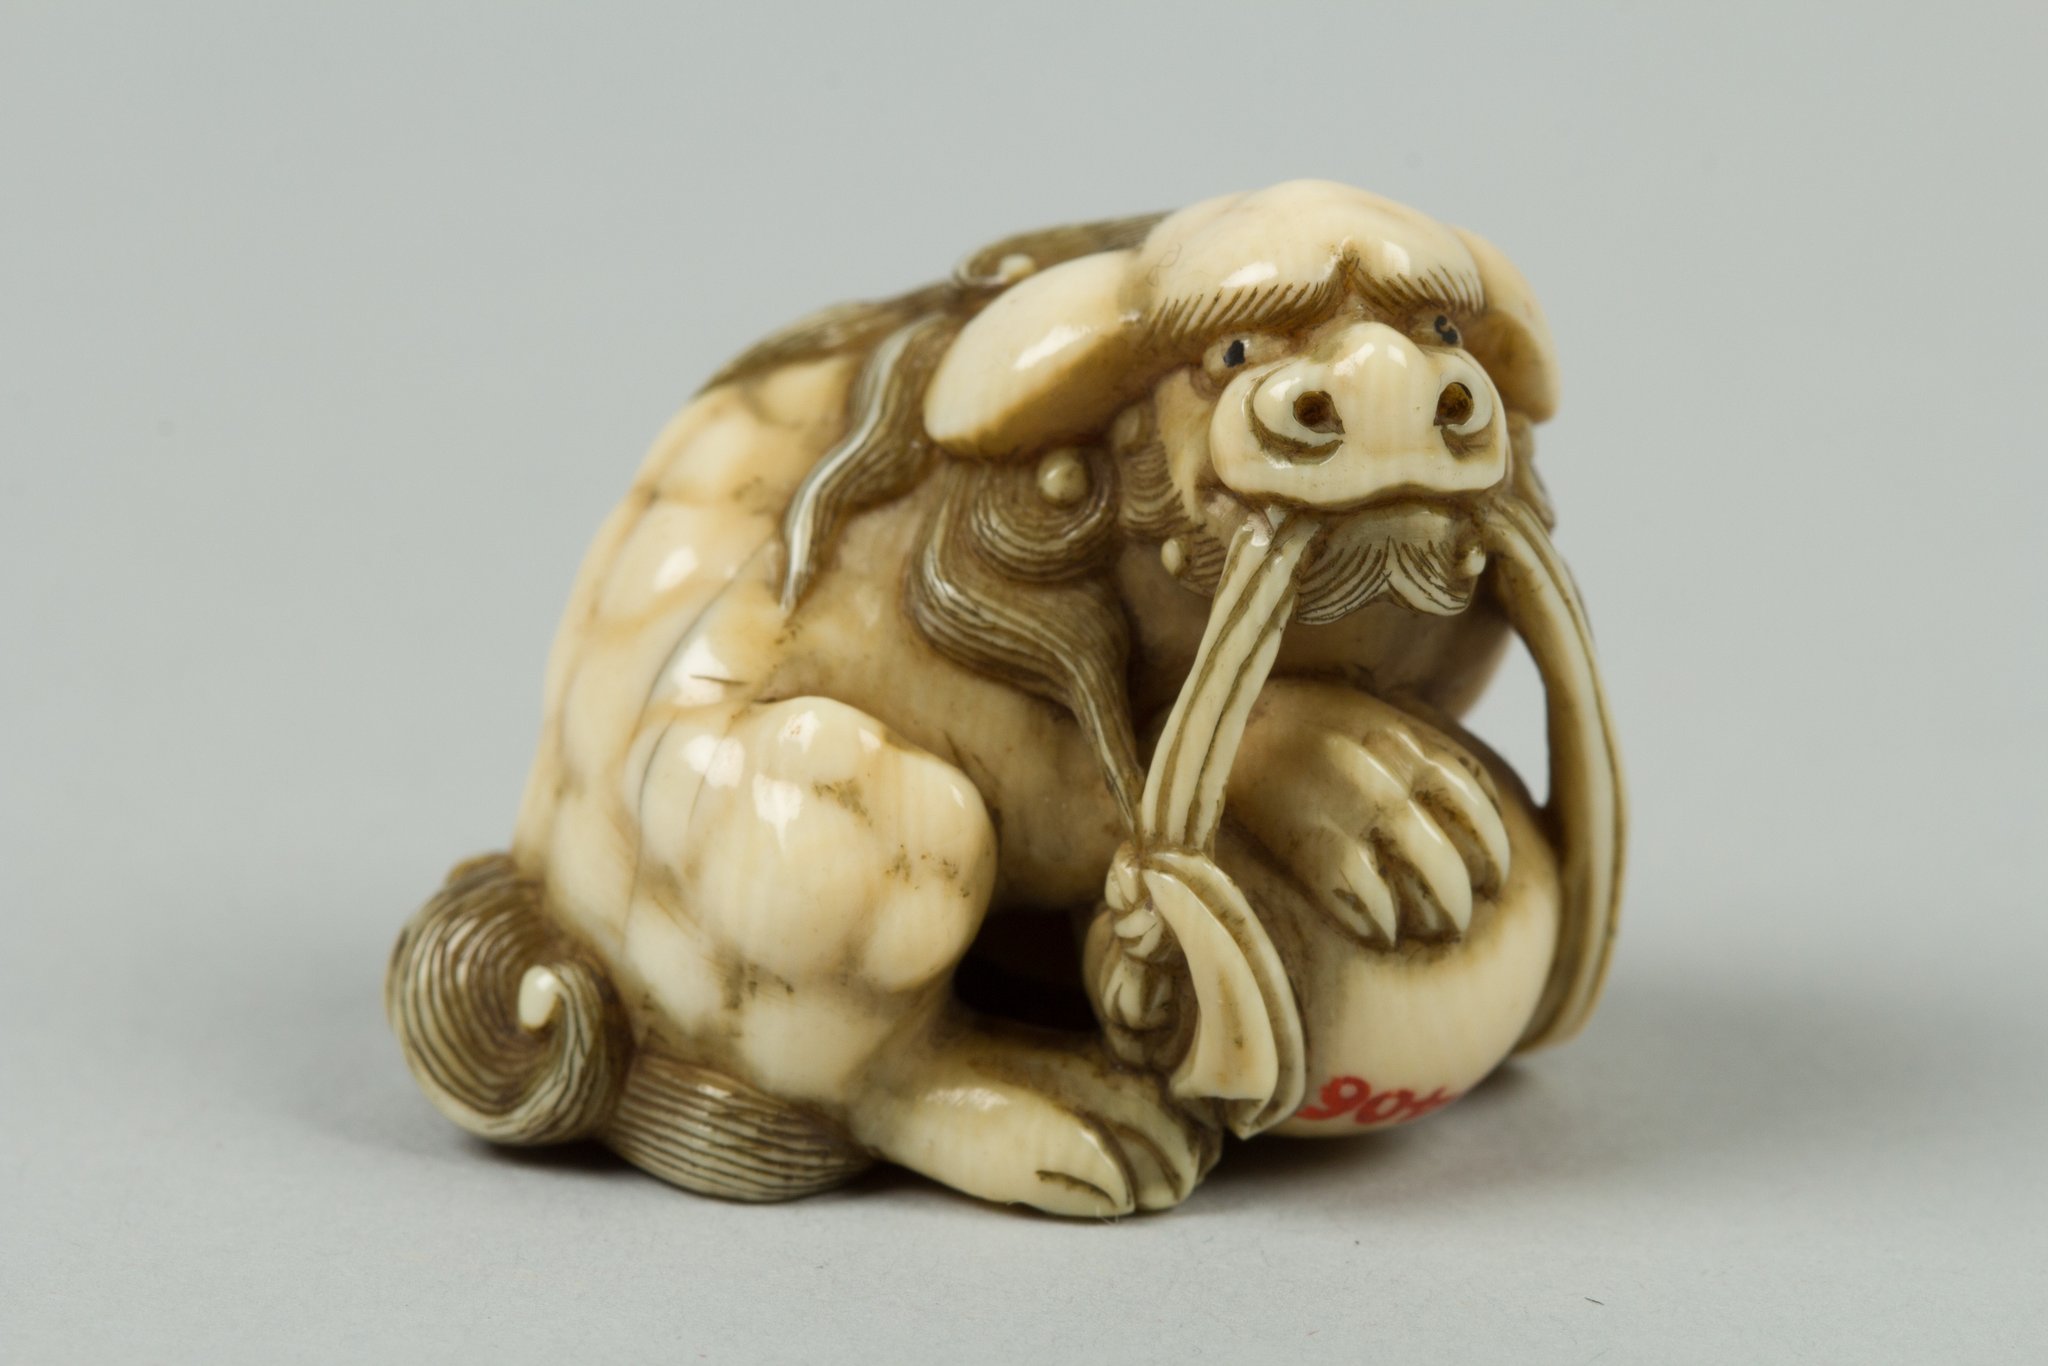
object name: netsuke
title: Netsuke of Qilin with a Ball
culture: japanese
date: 1801-1900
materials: ivory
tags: mythical creatures